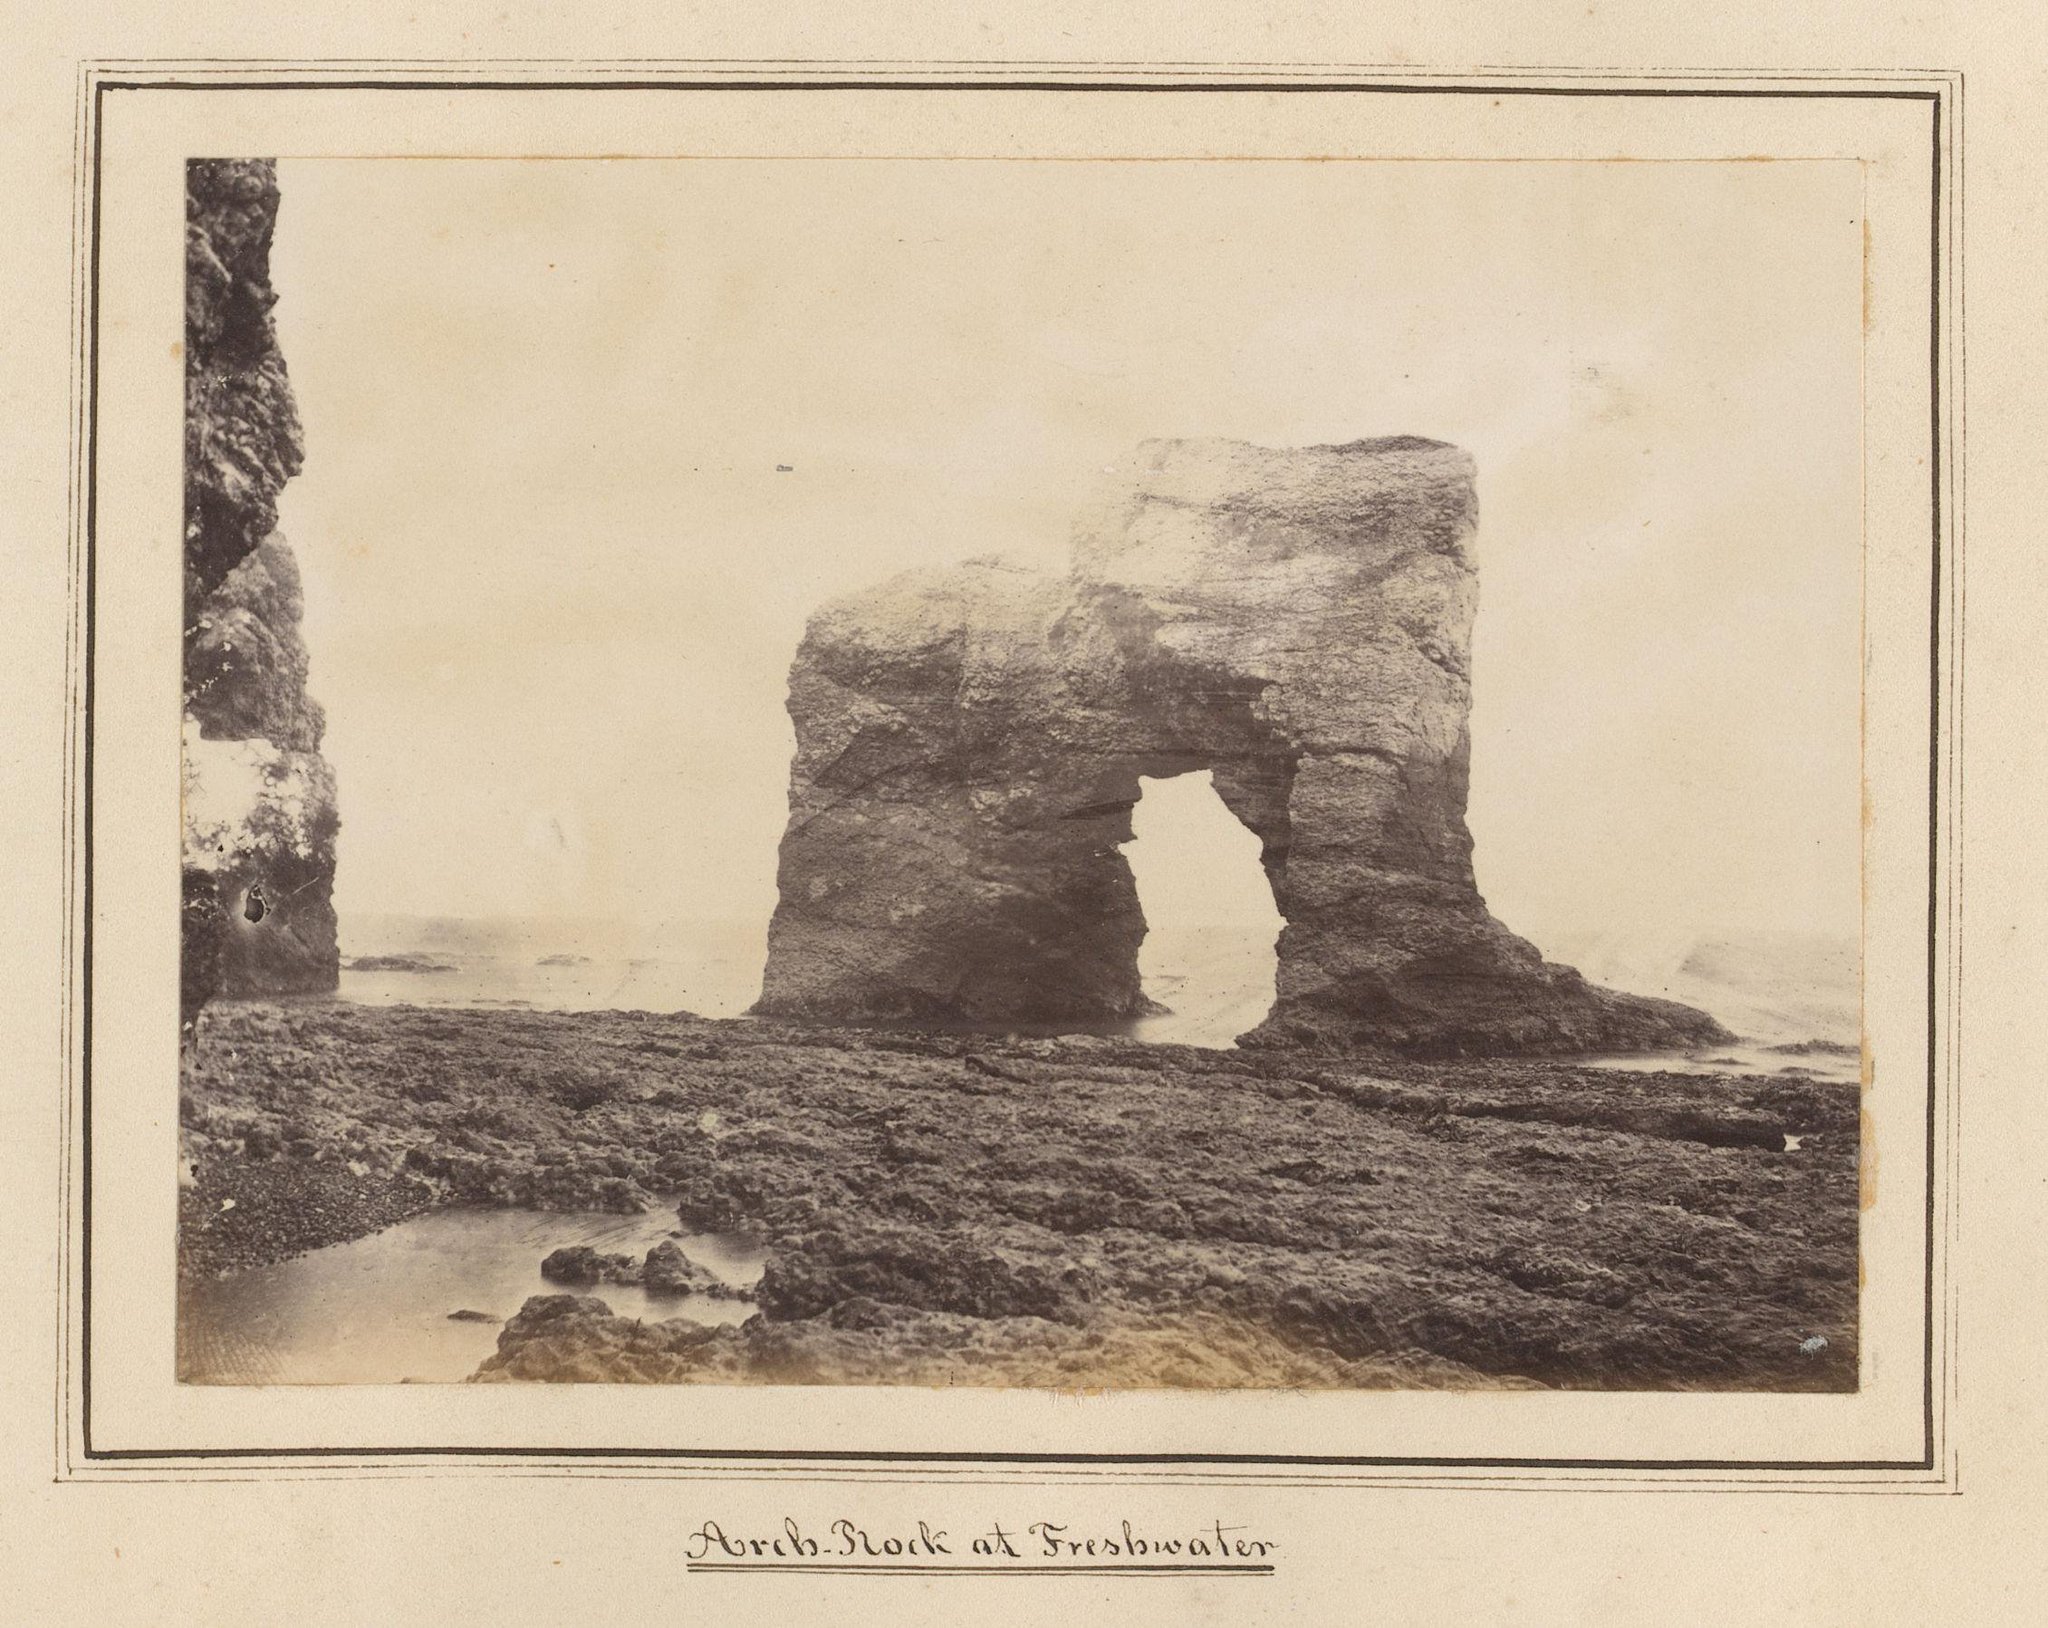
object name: album leaf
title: Arch-Rock at Freshwater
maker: Anonymous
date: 1870-1890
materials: paper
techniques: albumen print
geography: freshwater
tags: rock-formations